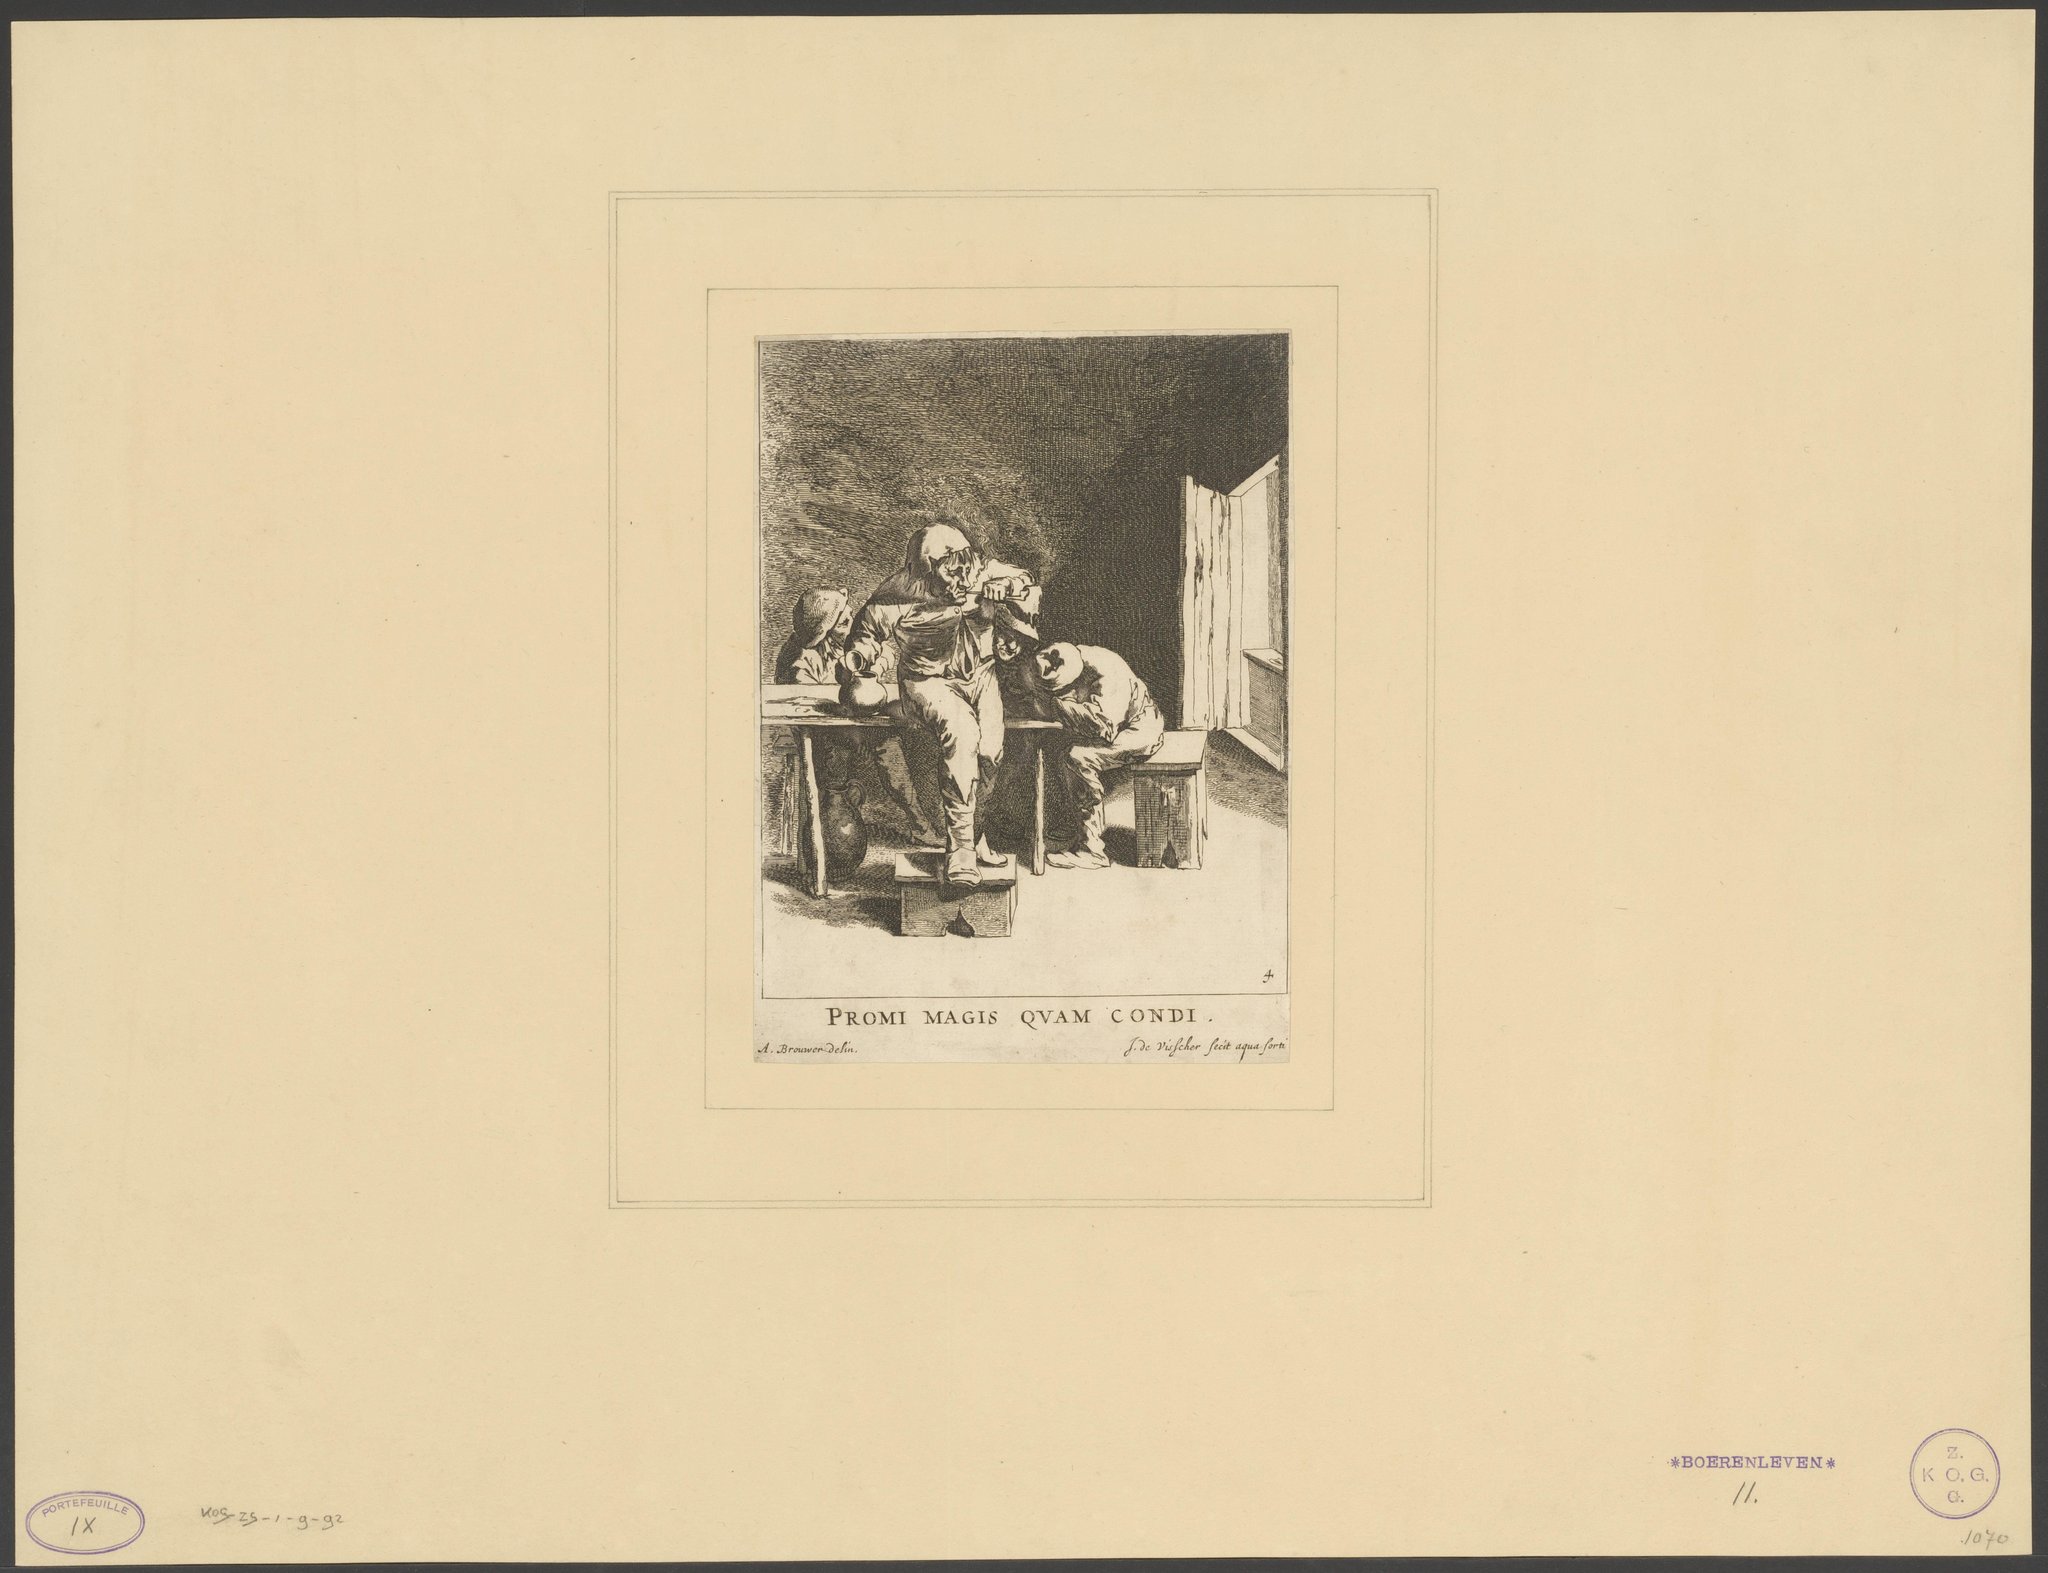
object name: print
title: Vier mannen bij een tafel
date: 1626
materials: paper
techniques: engraving, etching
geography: antwerp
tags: farmers, tobacco, hotel, hostelry, inn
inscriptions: stamp, stamp, collector's mark: Lugt 1641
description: In een eenvoudig interieur zijn vier mannen rond een tafel gepositioneerd. Een van de mannen staat op een krukje en rookt zijn pijp. Een andere man ligt met zijn hoofd op de tafel. Rechtsonder genummerd: 4. Onderwerpsrubrieken binnen de Atlas Zeden en Gewoonten: Handel, nijverheid en verkeer, Boerenleven.